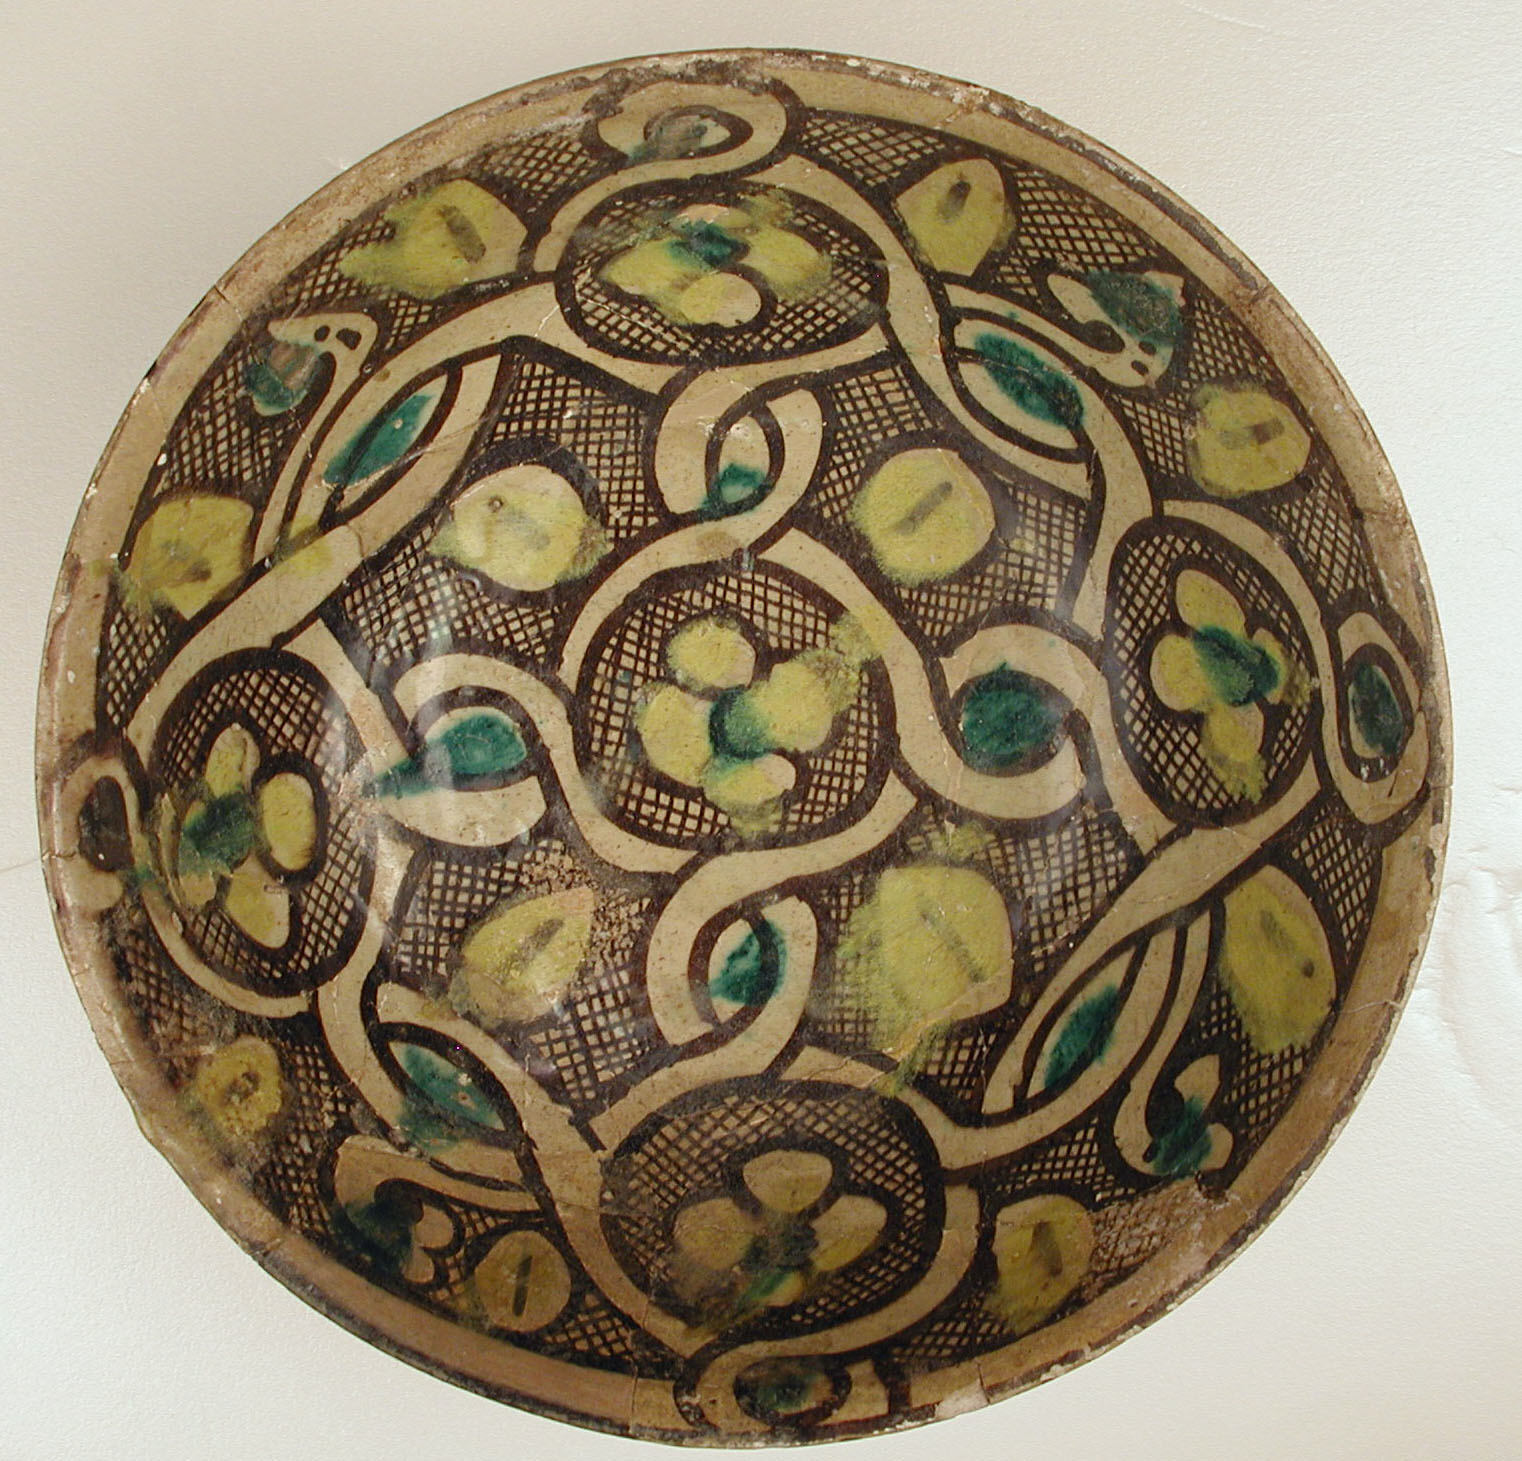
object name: bowl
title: Bowl with Interlace Pattern and Yellow Flowers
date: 801-900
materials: earthenware, glaze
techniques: polychrome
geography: iran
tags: flowers